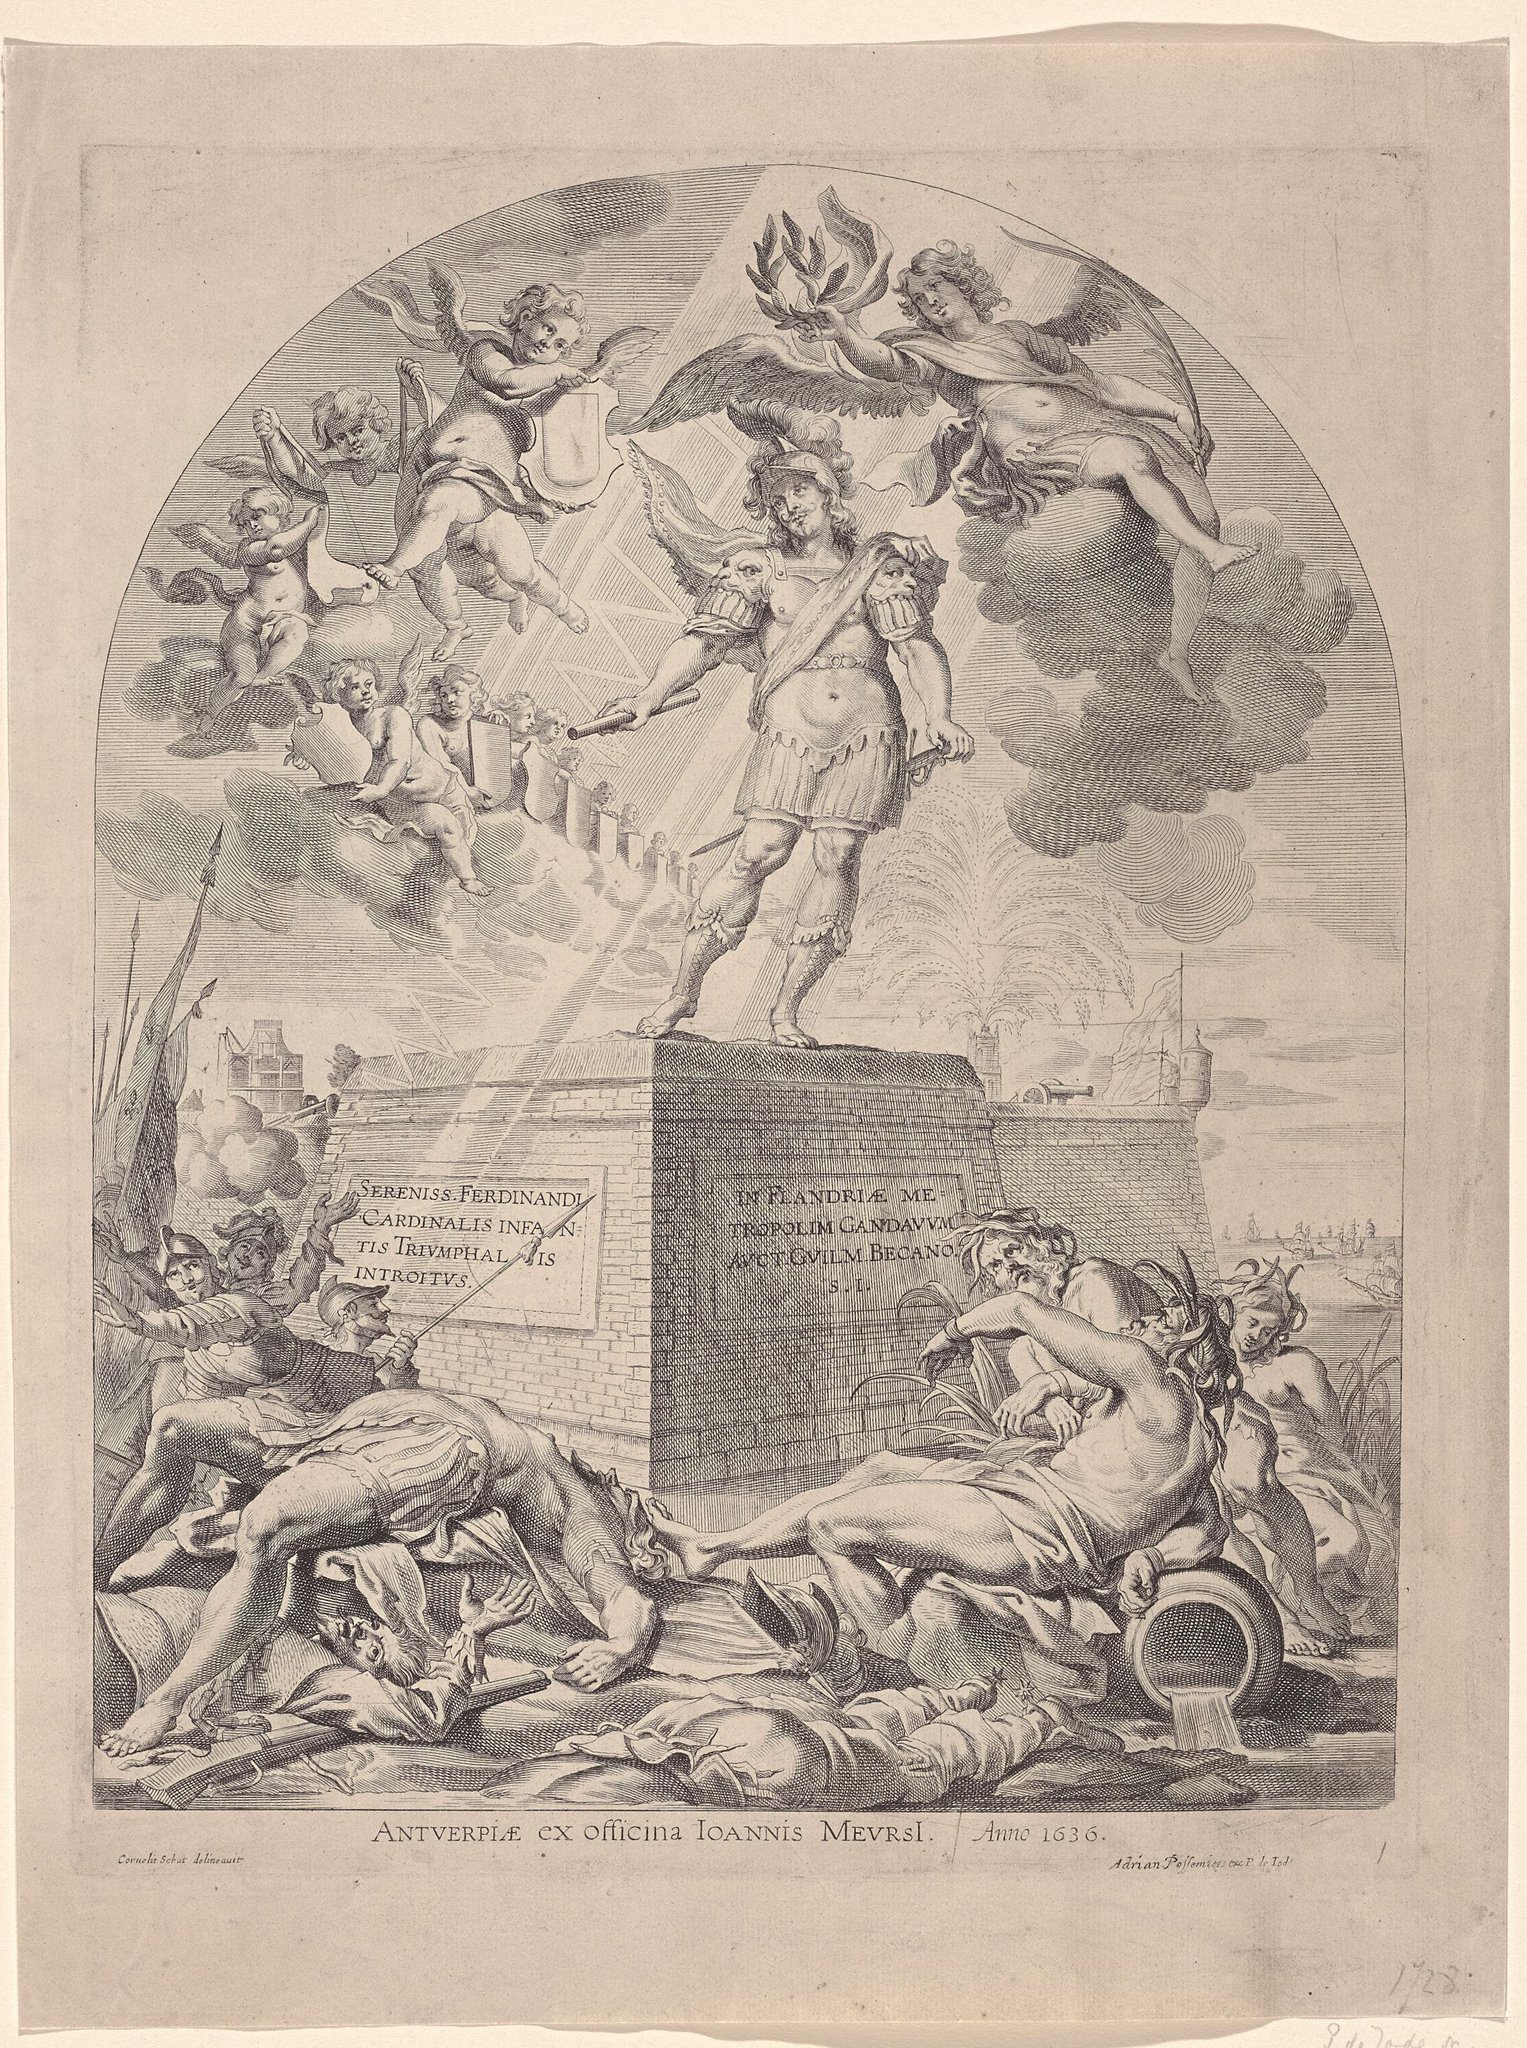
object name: print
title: Frontispice met Ferdinand als Mars; intocht van Ferdinand te Gent in 1635 (nr. 1)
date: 1635-1636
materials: paper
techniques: engraving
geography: southern netherlands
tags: landvoogd der zuidelijke nederlanden ferdinand van oostenrijk, triumphal entry and public reception, pageant, 'entrée solennelle', 'joyeuse entrée', ghent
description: Frontispice met kardinaal Ferdinand als Mars, staande op een voetstuk, gelauwerd door de Victorie. Op de grond verslagen vijanden en riviergoden. Blad nr. 1 in een geheel van 42 platen die de uitgave van de beschrijving van de intocht van de Kardinaal Infant Ferdinand van Oostenrijk te Gent op 28 januari 1635 als de nieuwe landvoogd voor de Spaanse Nederlanden illustreren.